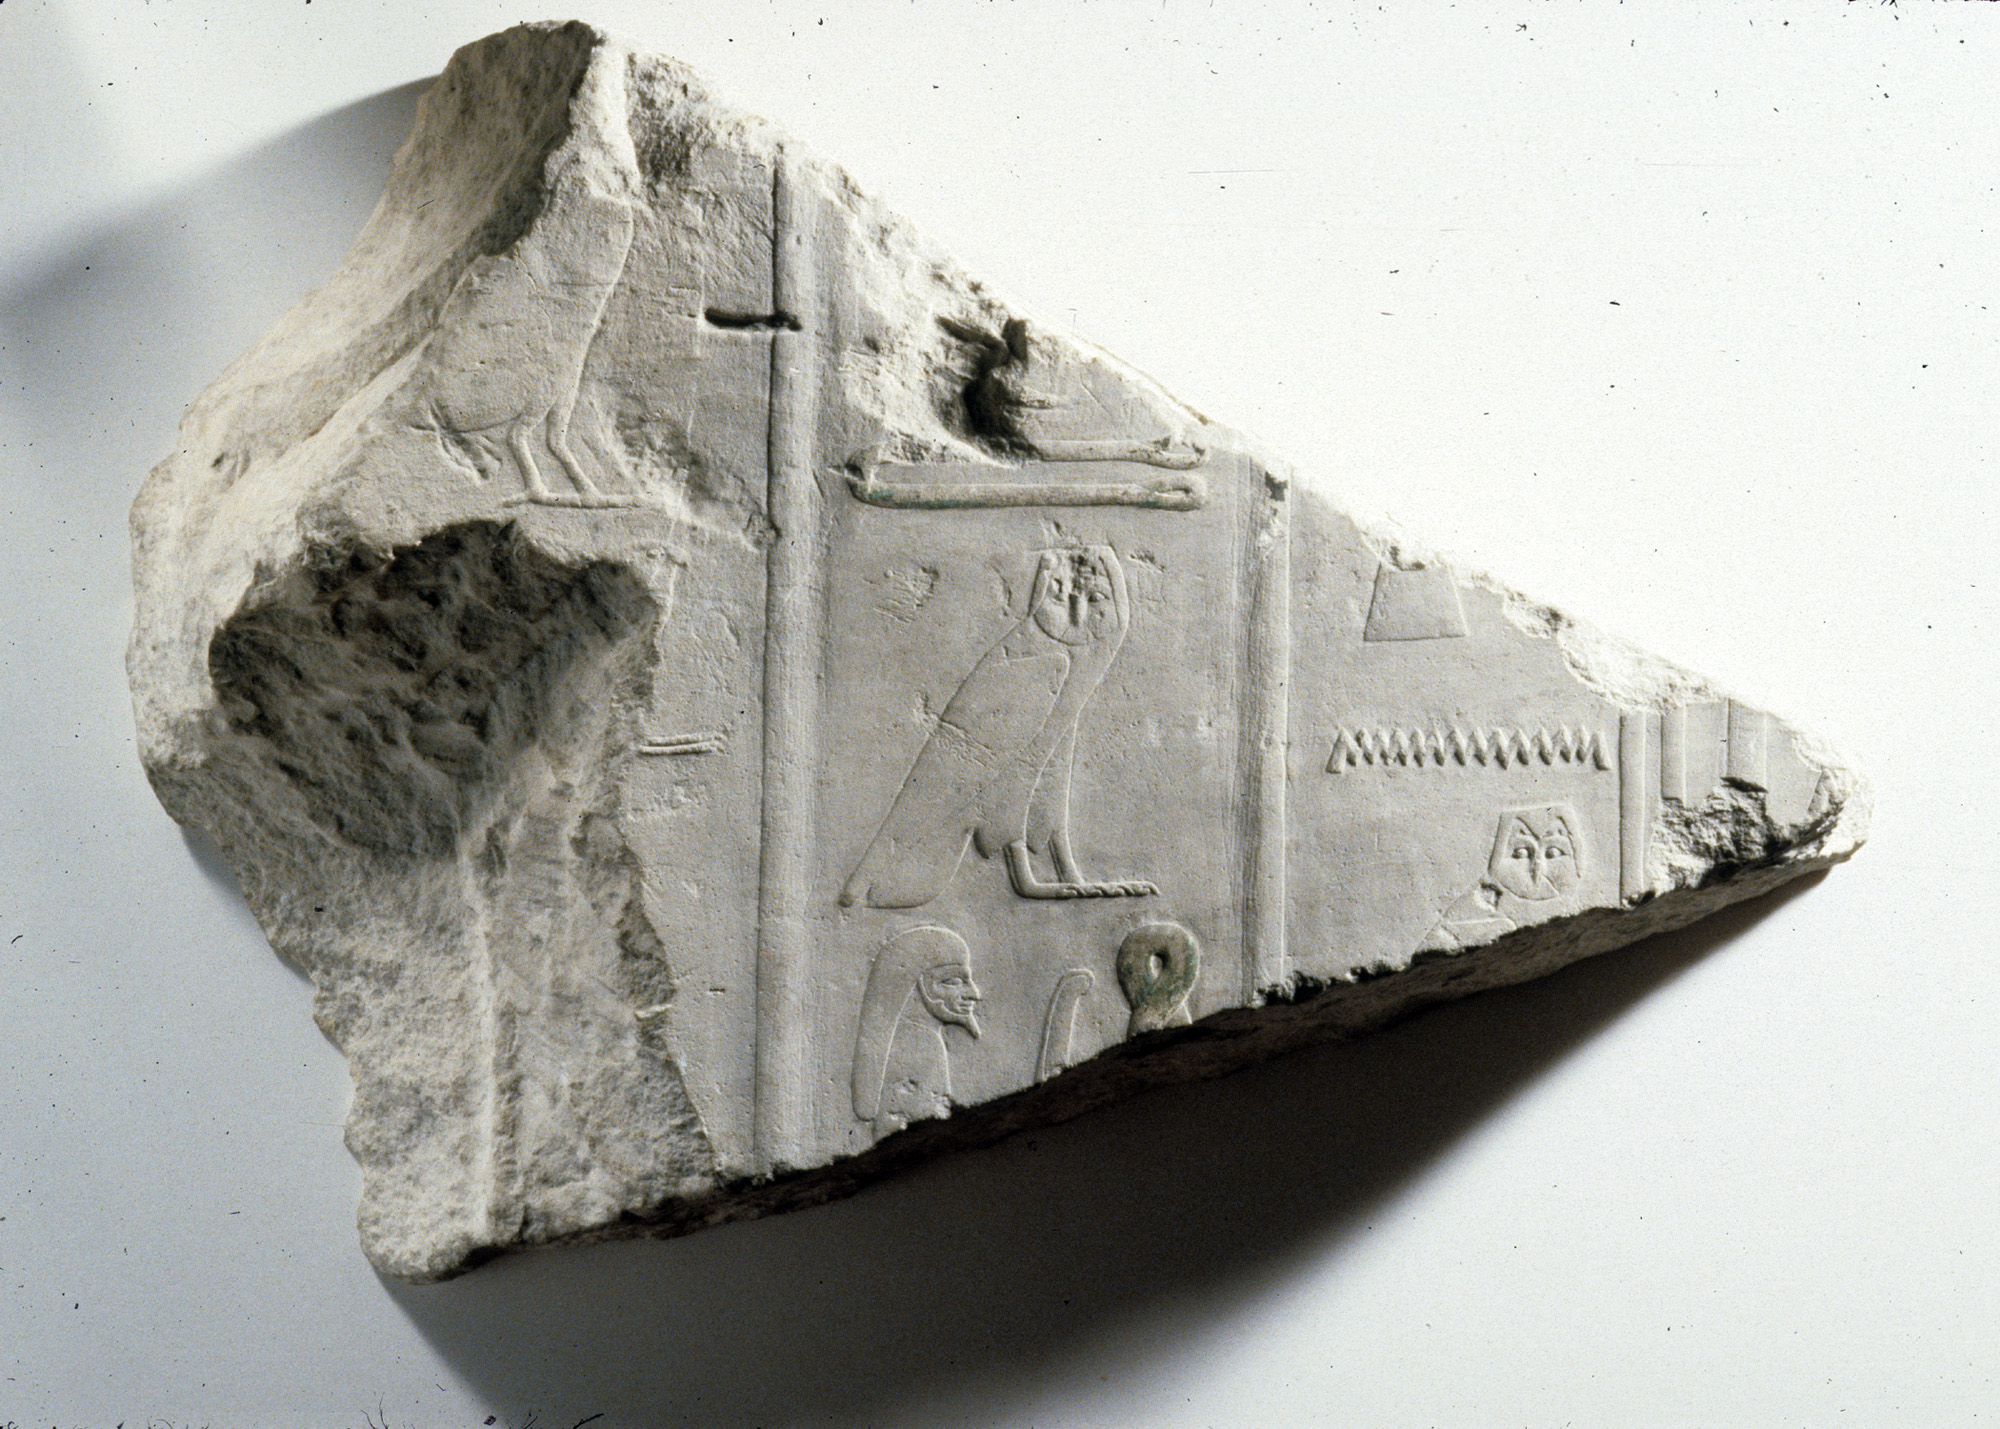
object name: relief, hieroglyphic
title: Relief of hieroglyphic inscription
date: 1961-1917 BCE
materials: limestone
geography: egypt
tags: hieroglyphs